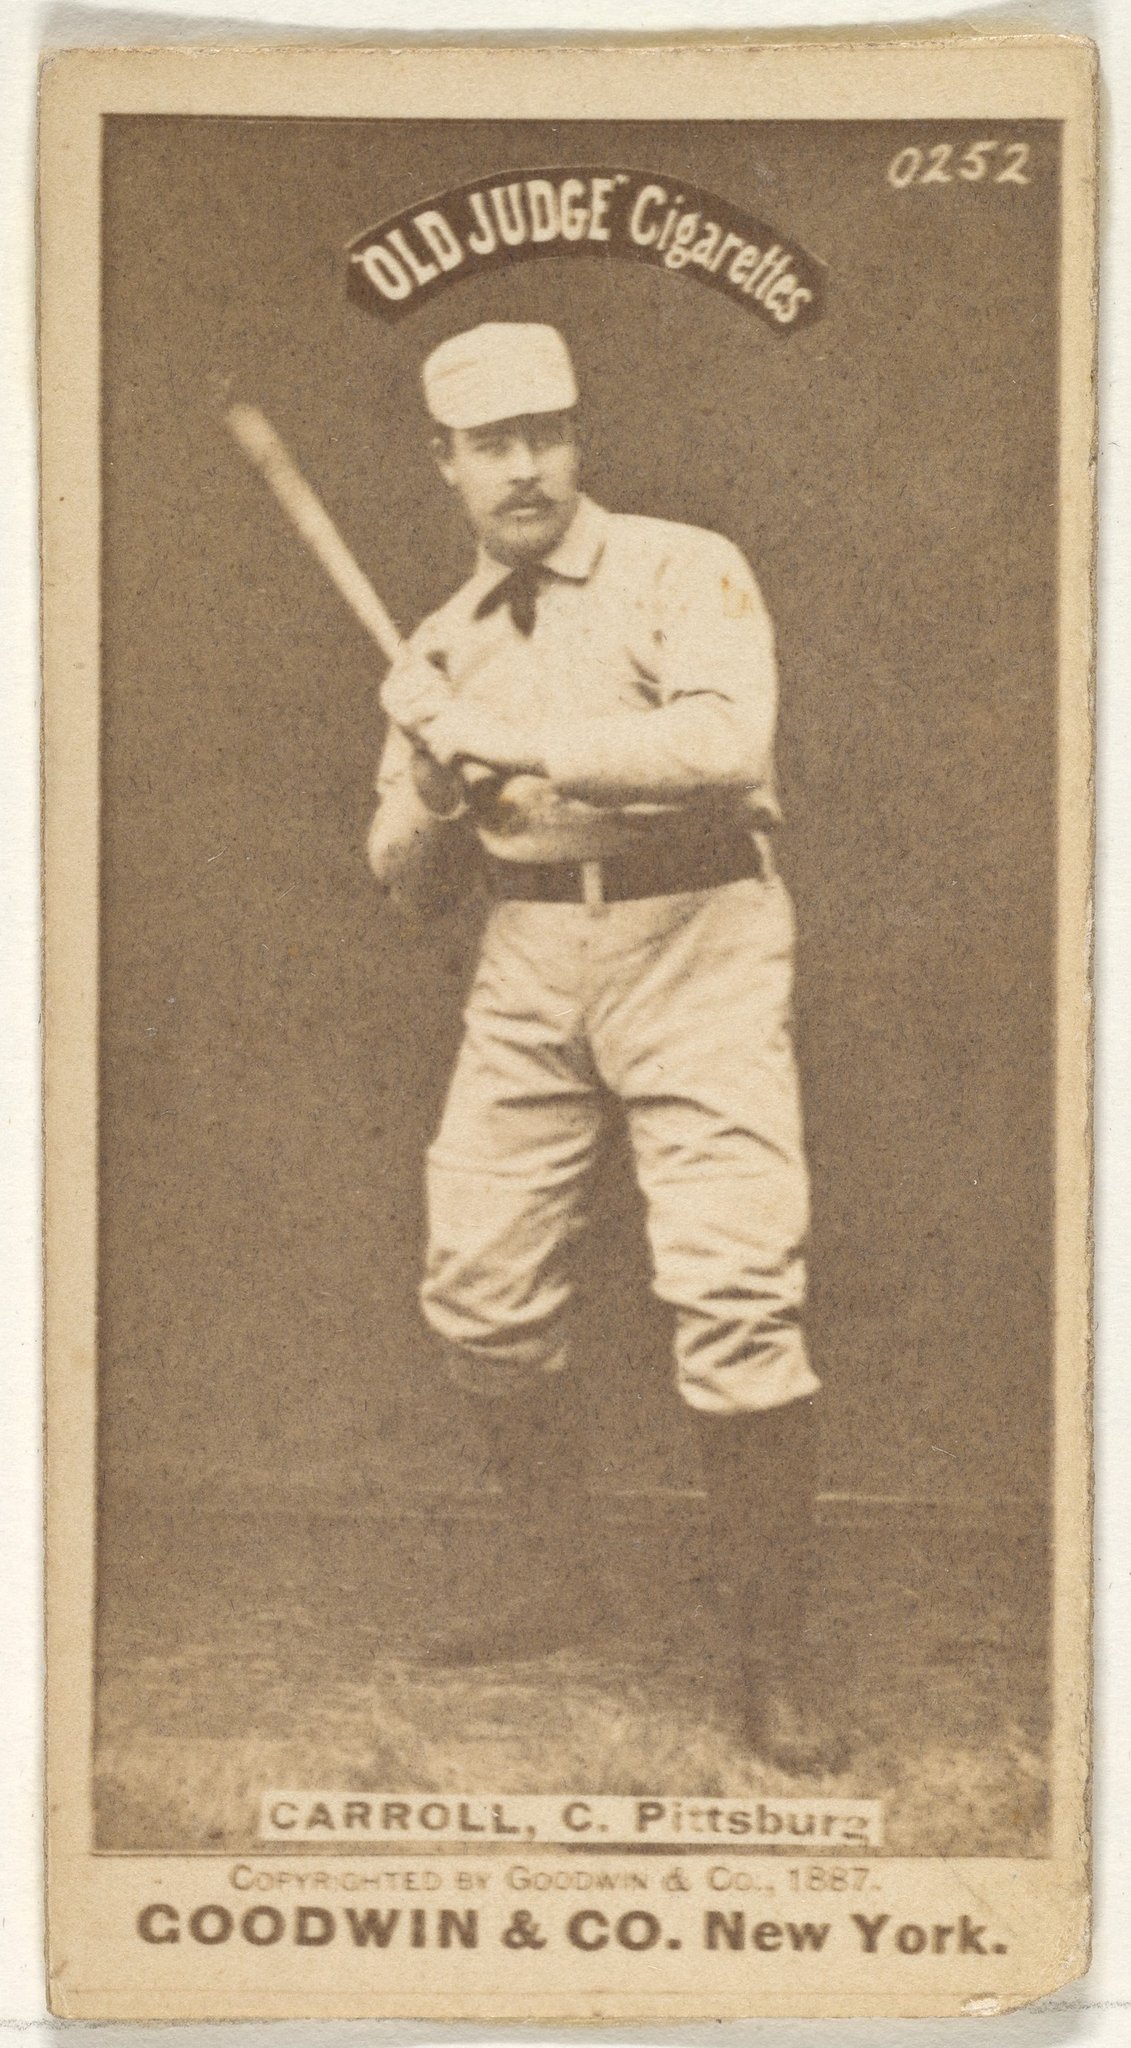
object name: baseball card, photograph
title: Frederick " Fred" Herbert Carroll, Catcher, Pittsburgh, from the Old Judge series (N172) for Old Judge Cigarettes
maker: goodwin & company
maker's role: publisher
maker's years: 1850-1950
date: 1887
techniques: albumen silver print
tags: men,portraits,baseball,athletes